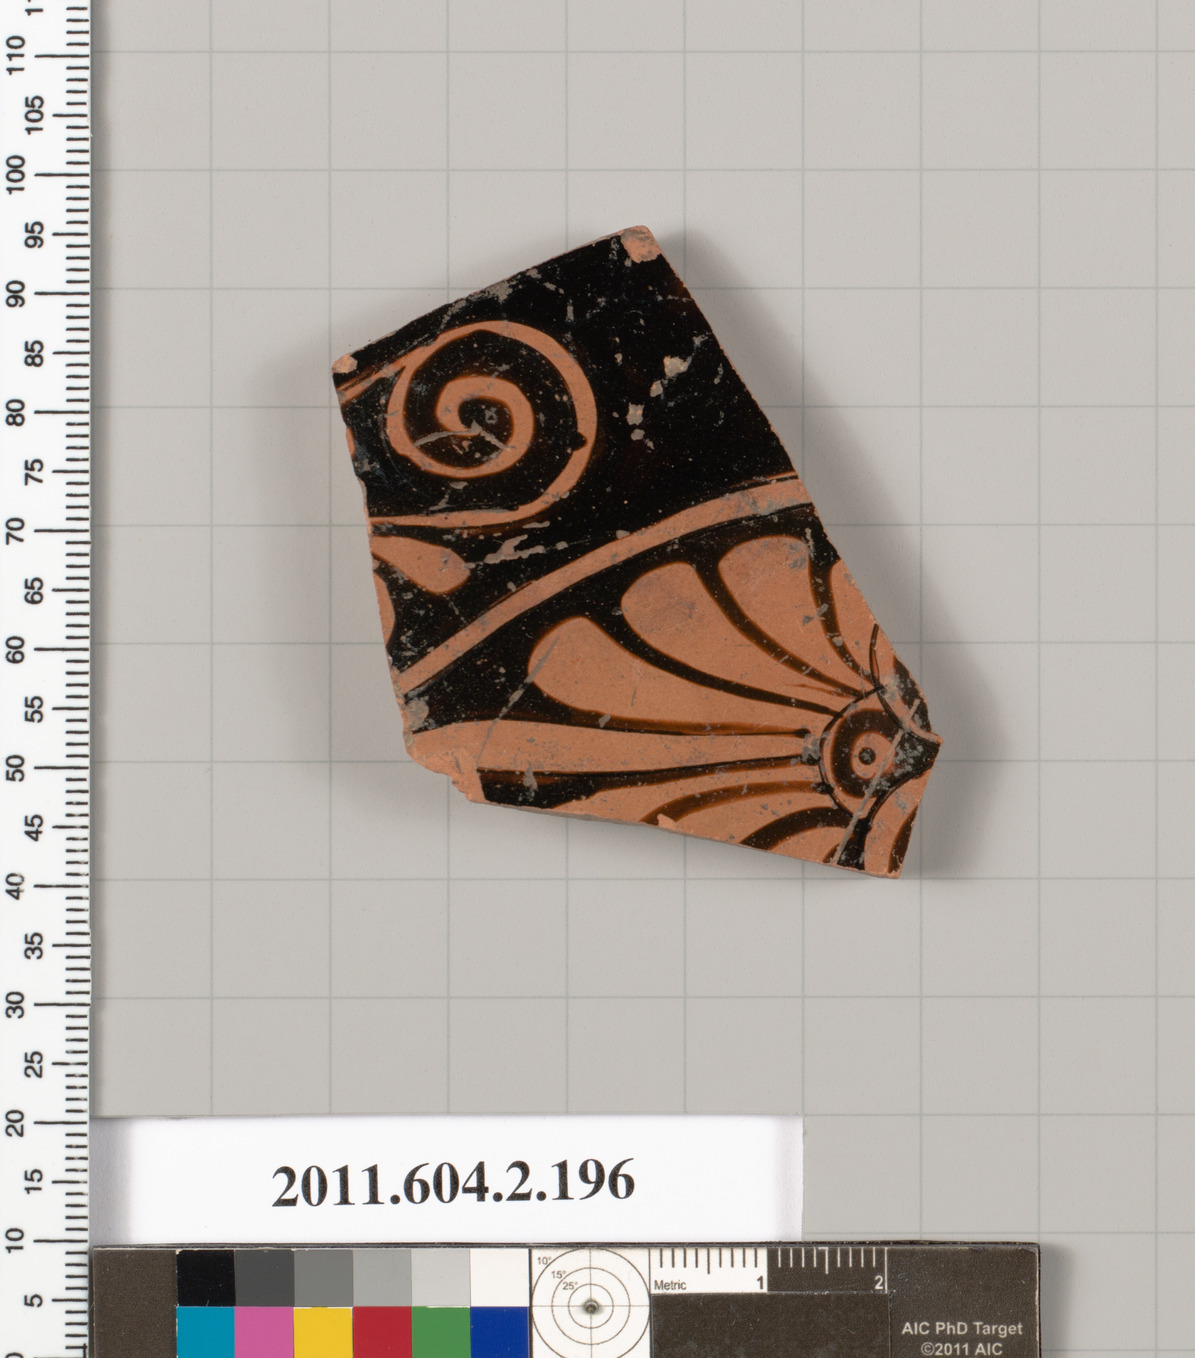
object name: stamnos fragment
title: Terracotta fragment of a stamnos (jar)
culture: greek, attic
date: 475-451 BCE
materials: terracotta